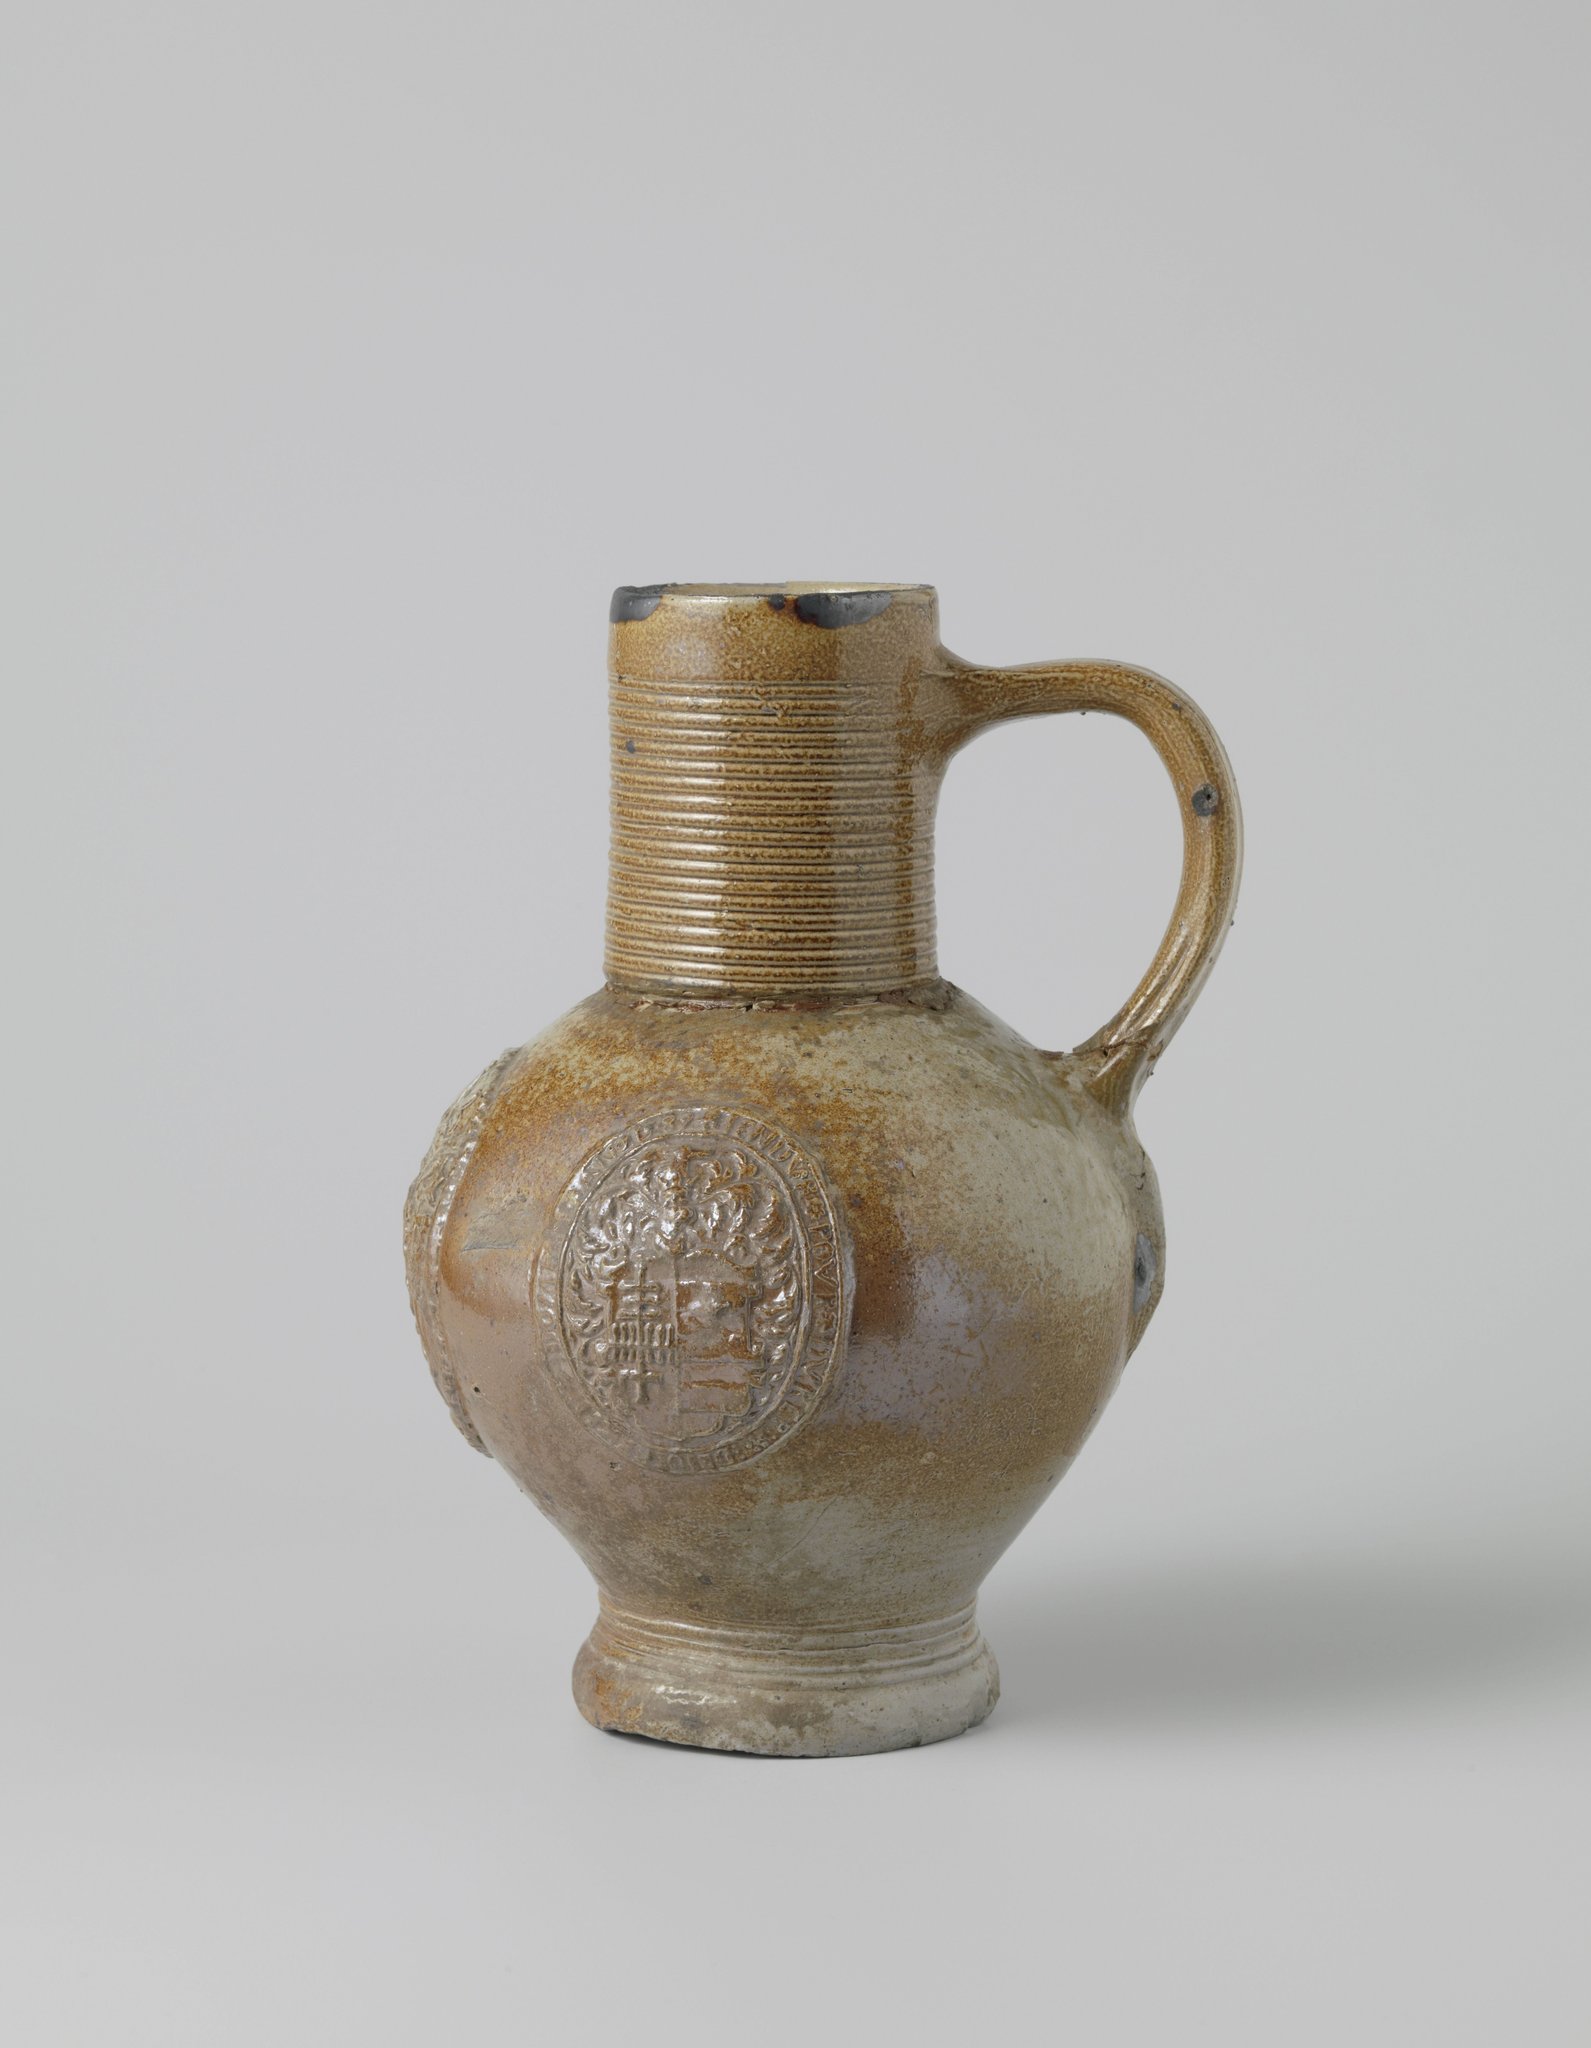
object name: jug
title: Jug with the coat of arms of Amsterdam and the d'Ombret family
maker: jan emens mennicken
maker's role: potter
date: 1590-1620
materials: engobe, glaze, stoneware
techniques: firing, forming, relief, turning, vitrification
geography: raeren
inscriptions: inscription: ‘IENDVR+POVR+DVRER+DEIDERRICH+DOMBRE+ANO:1589’, inscription: ‘AMSTER/ EE 85’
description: Kruik van steengoed op hoge voet met een bolvormig lichaam en wijde, geribde nek. Het C-vormige oor is bevestigd aan de nek en de schouder. Profielen op de voet. Bedekt met een bruine engobe. Op de buik in reliëf drie gedrukte en opgelegde medaillons met een wapen. In het midden het gekroonde wapen van Amsterdam met het opschrift 'AMSTER' en 'EE 85'. Aan weerszijden hiervan het wapen van de familie d'Ombret (Luik) met het randschrift 'IENDVR+POVR+DVRER+DEIDERRICH+DOMBRE+ANO:1589'. Raeren.